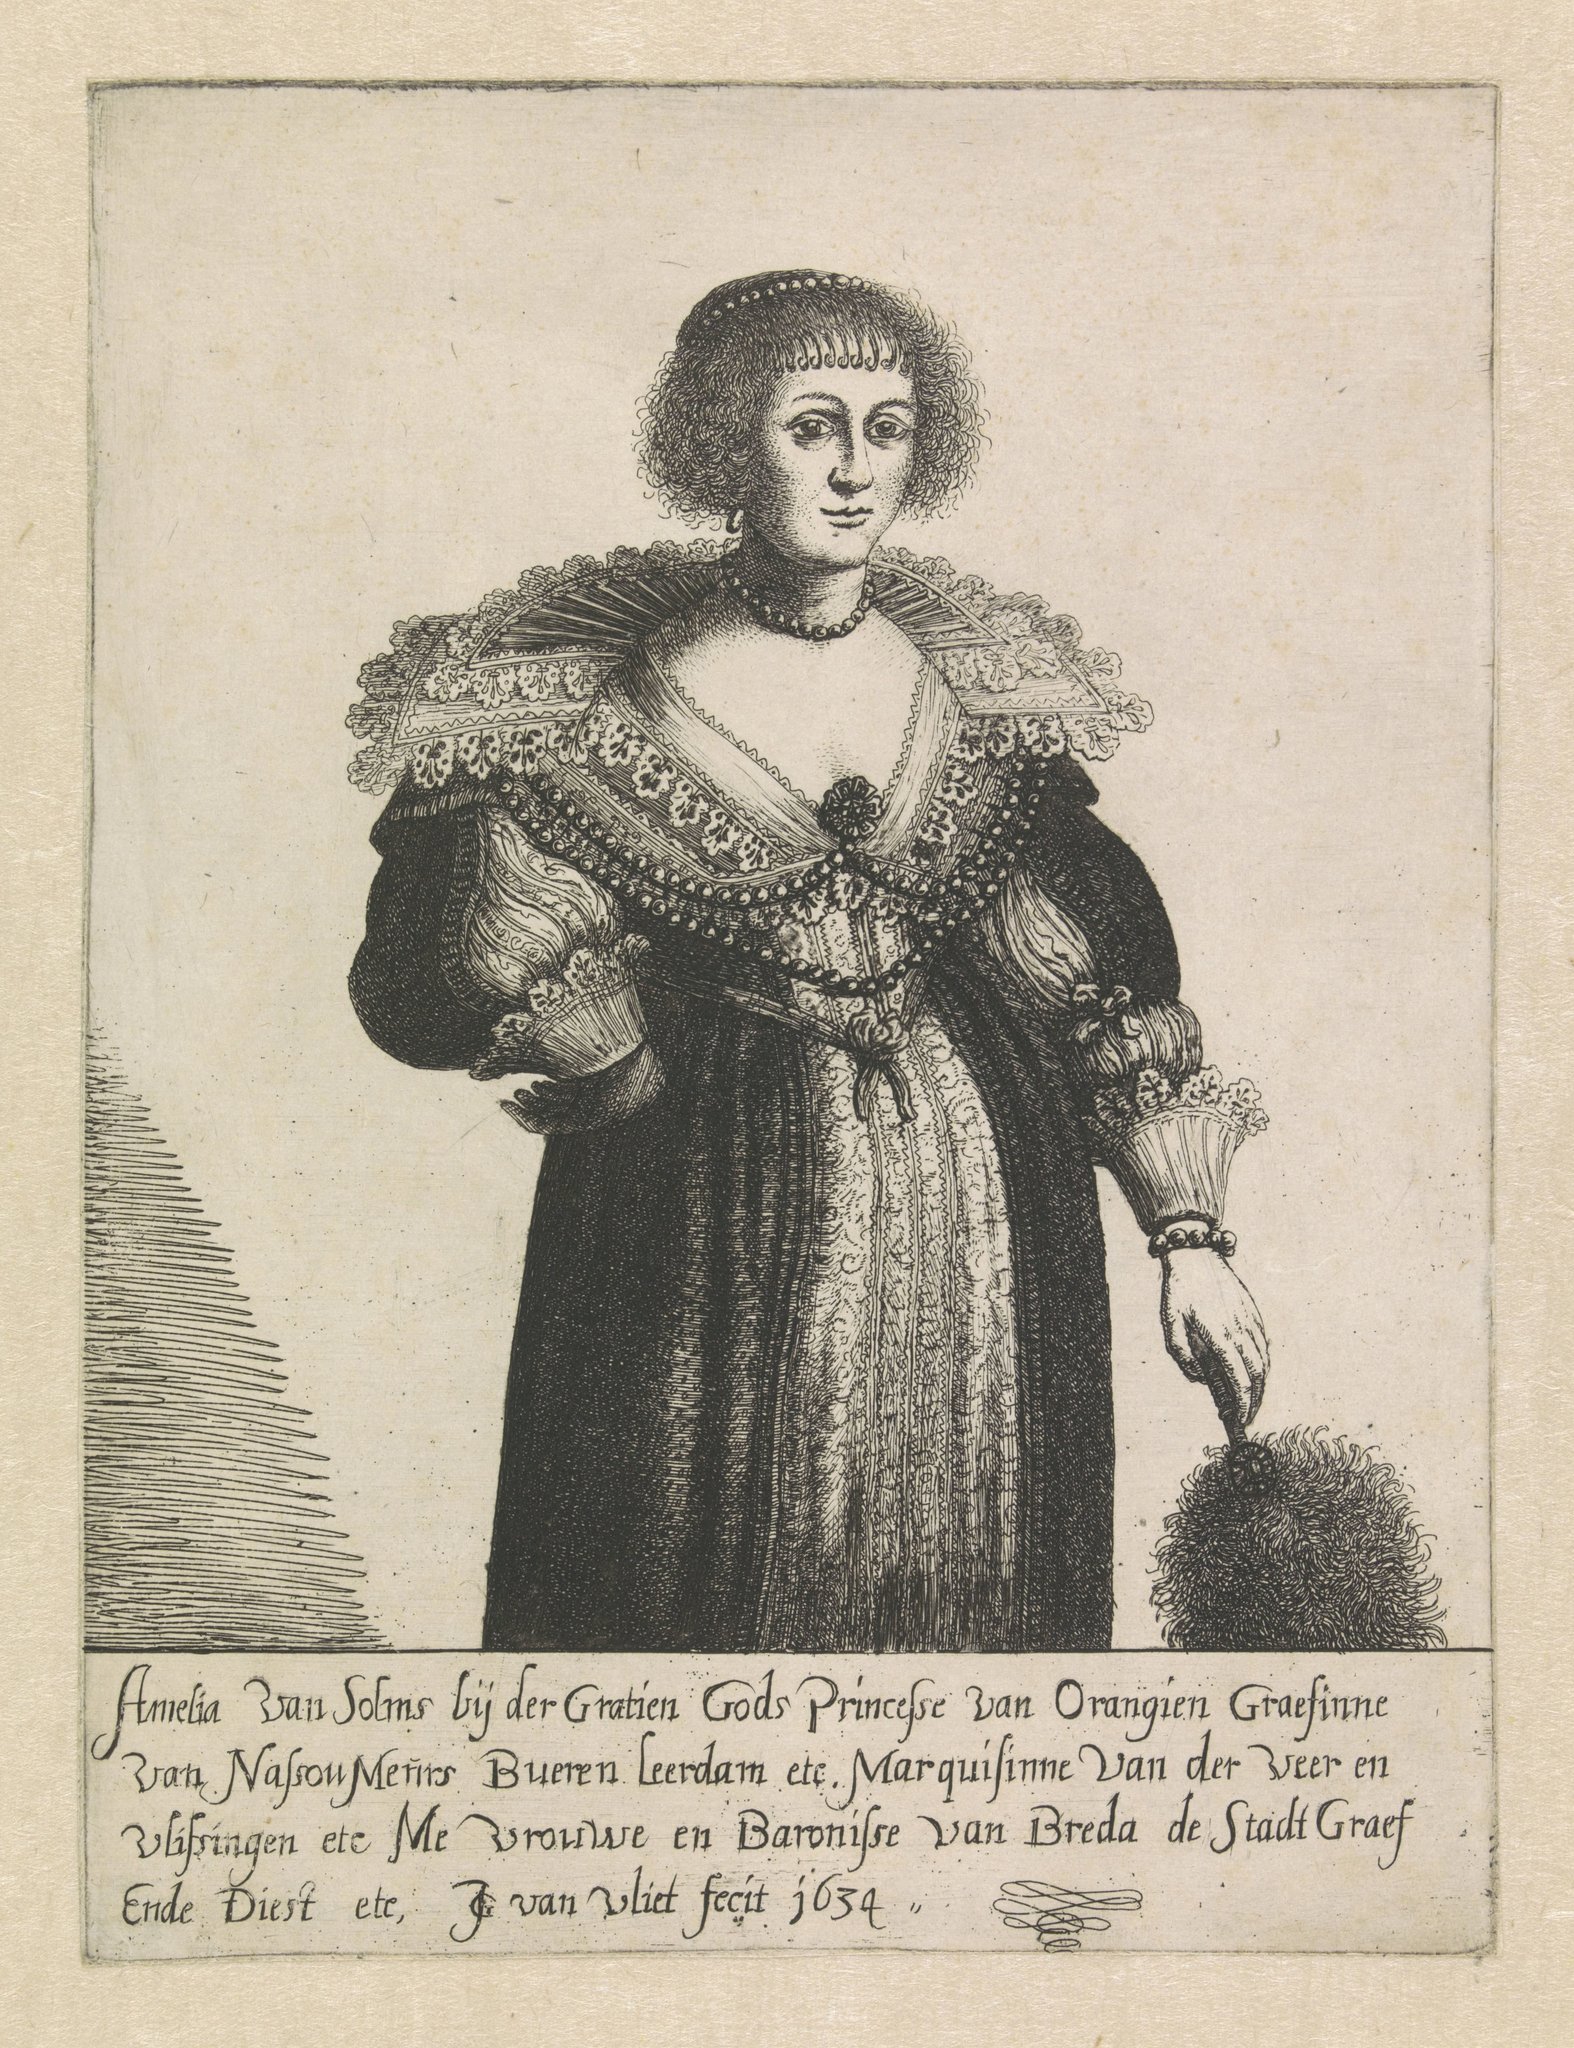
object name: print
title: Portret van Amalia van Solms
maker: jan gillisz. van vliet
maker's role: draughtsman, painter, print maker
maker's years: 1600-1668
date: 1634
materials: paper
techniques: etching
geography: low countries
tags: the hague, amalia of solms-braunfels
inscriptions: collector's mark: Lugt 2228, inscription: ‘N. 6510 very rare I gave for the pair £ 1,,11,,6’, inscription: ‘P. mariette 1661’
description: Portret van Amalia met in haar linkerhand een waaier. In de ondermarge vier regels Nederlandse tekst.